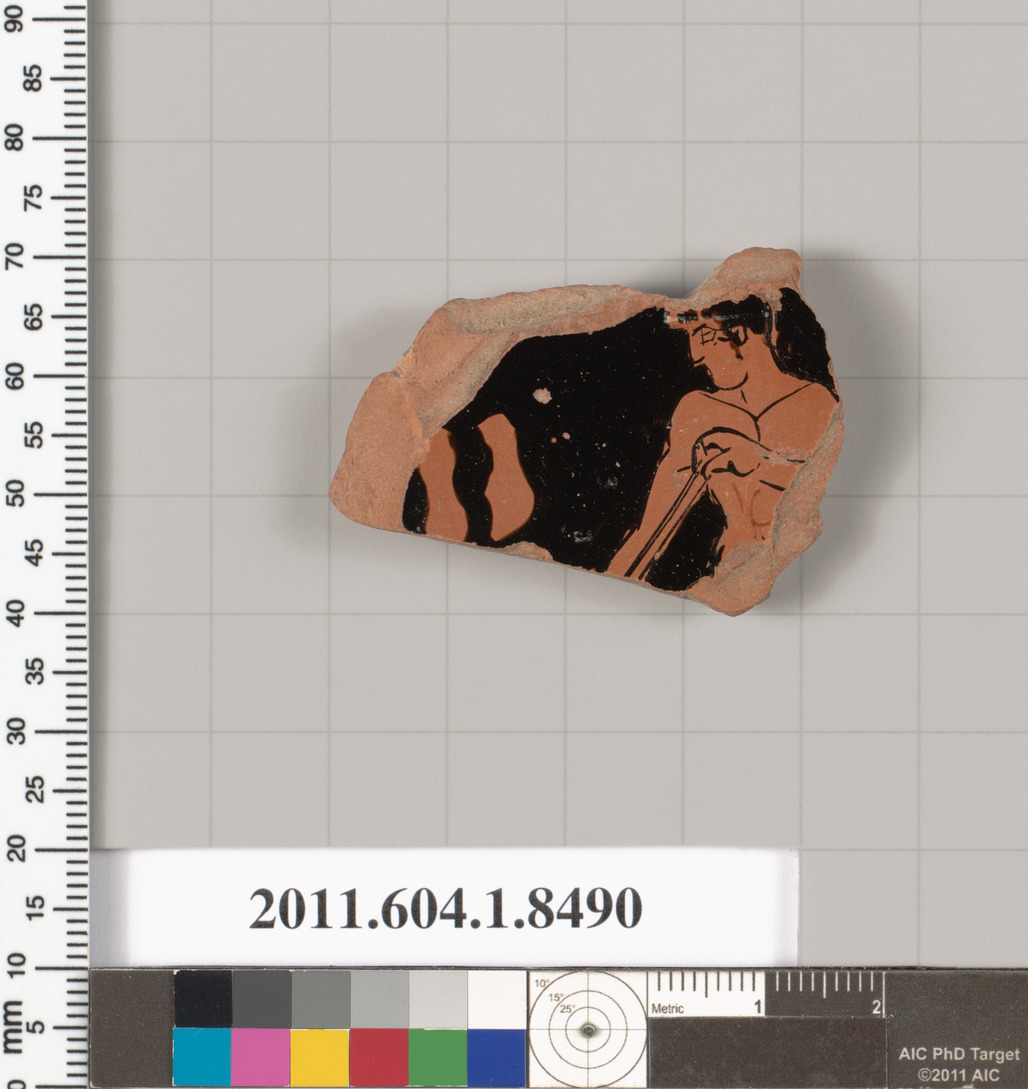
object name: kylix fragment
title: Terracotta fragment of a stemless kylix (drinking cup)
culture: greek, attic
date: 460-450 BCE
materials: terracotta